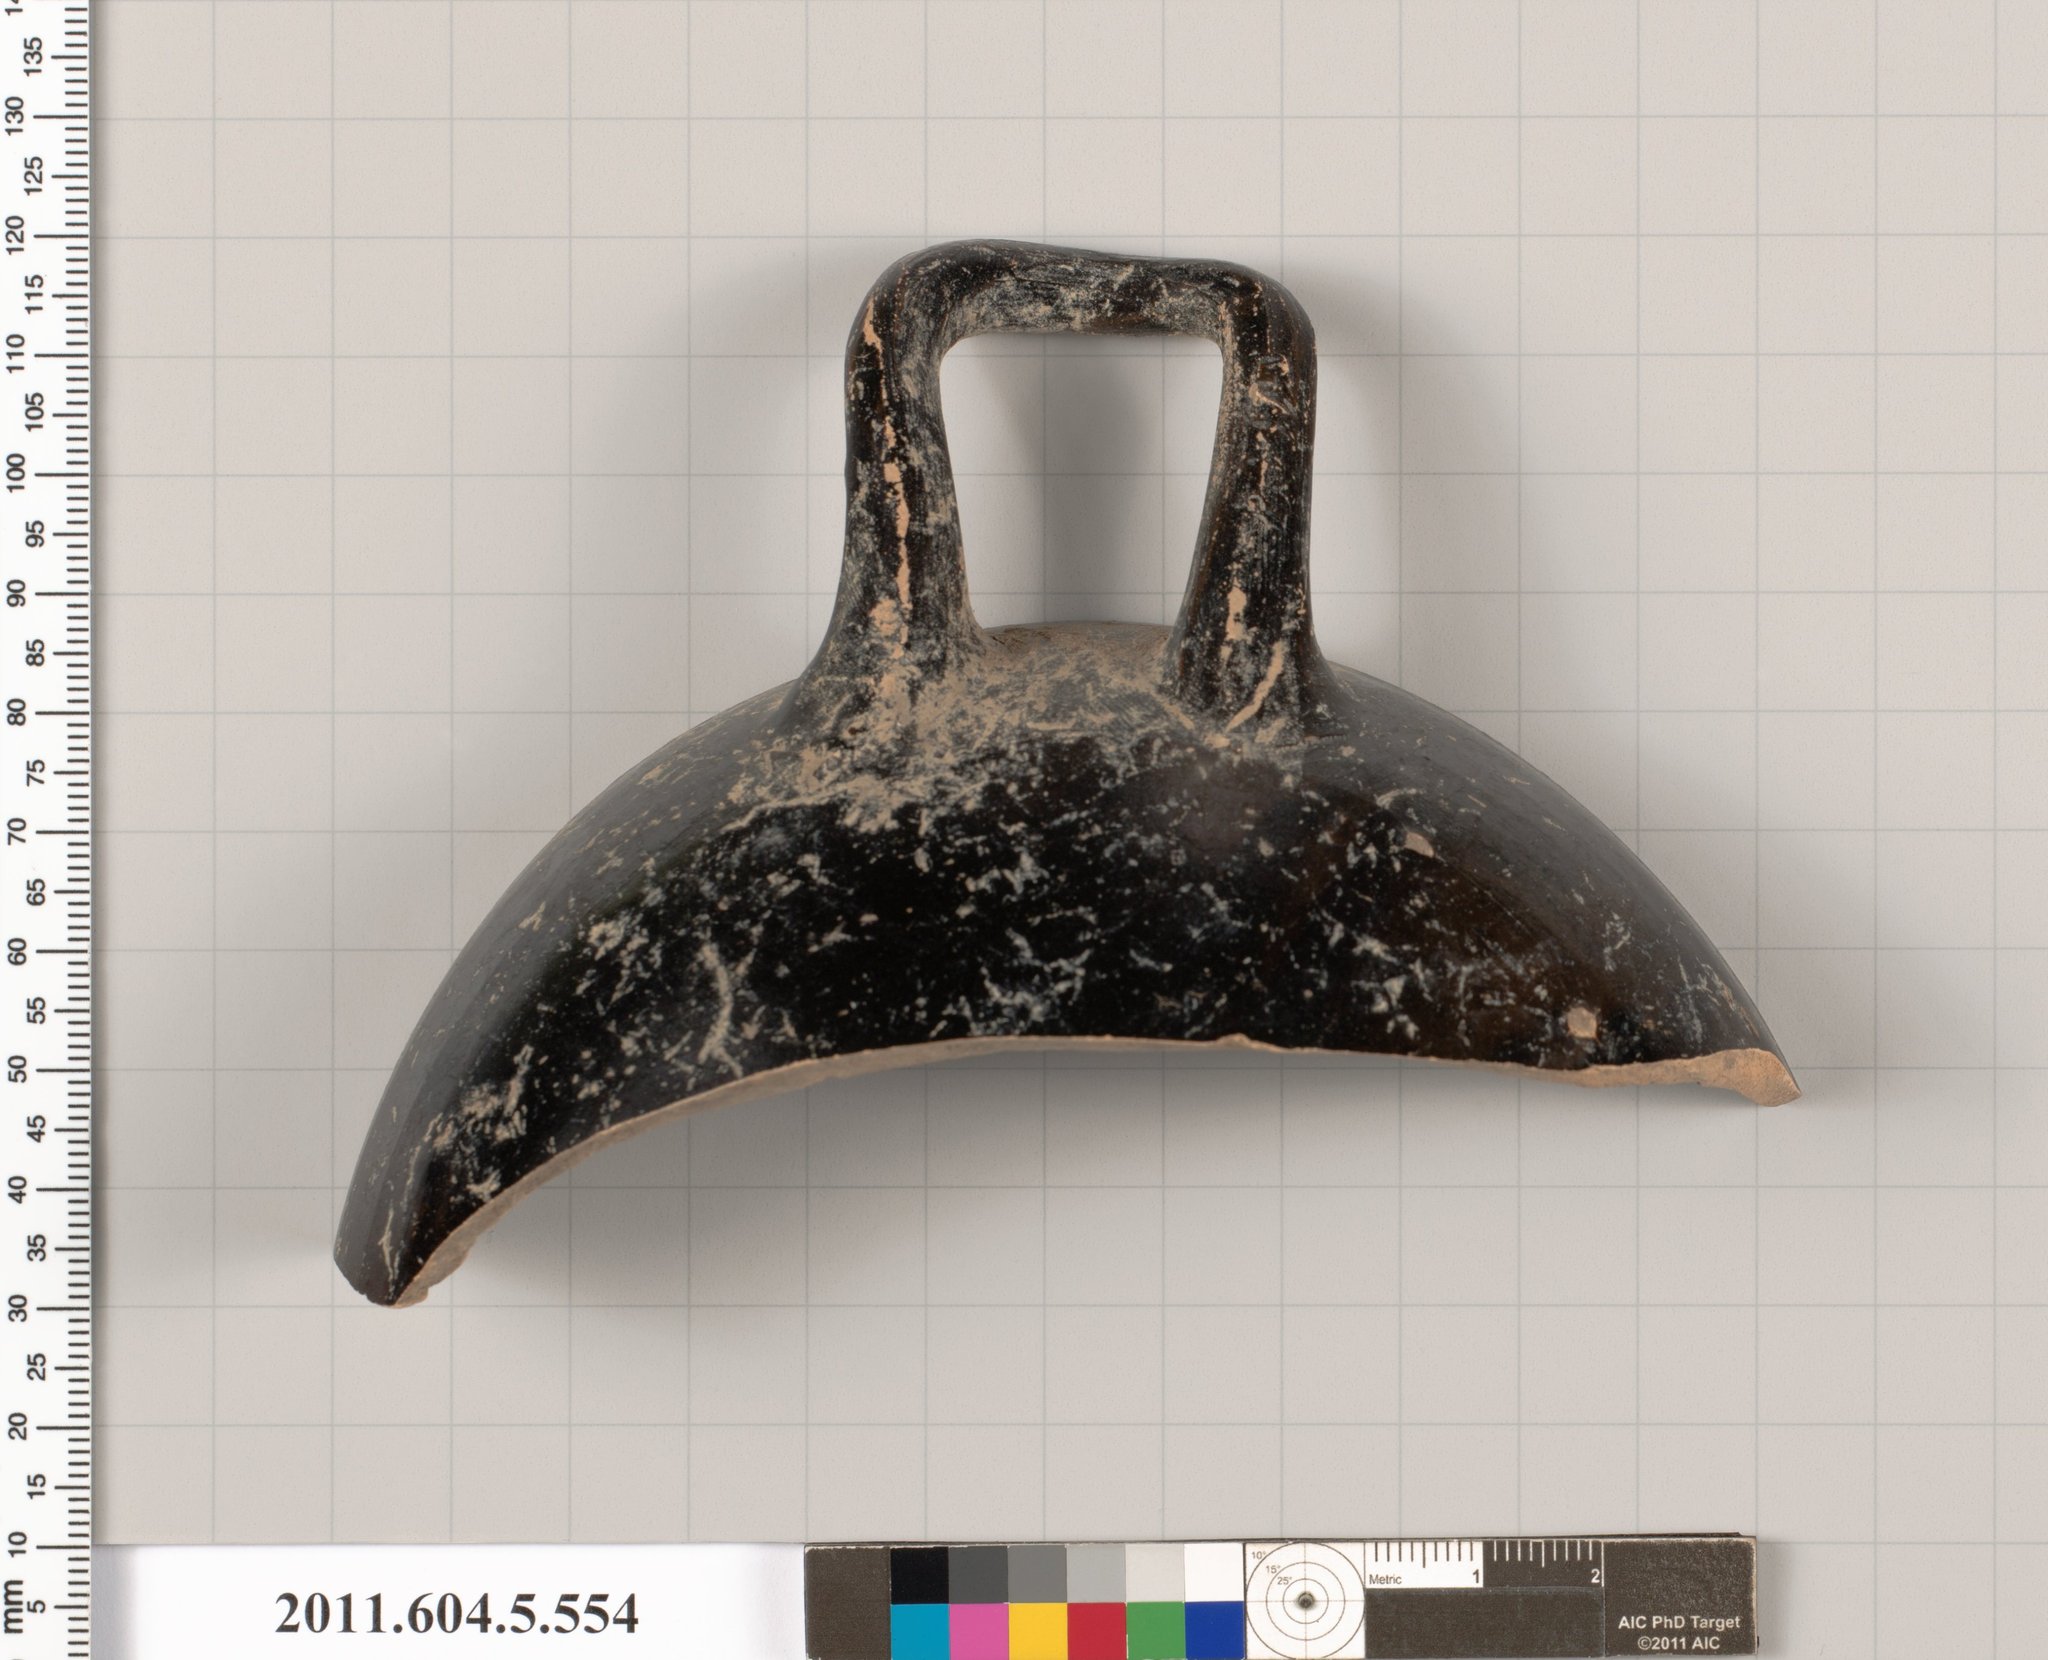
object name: kylix or skyphos fragment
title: Terracotta fragment of a kylix (drinking cup) or a cup-skyphos (drinking cup?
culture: greek, attic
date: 600-401 BCE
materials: terracotta